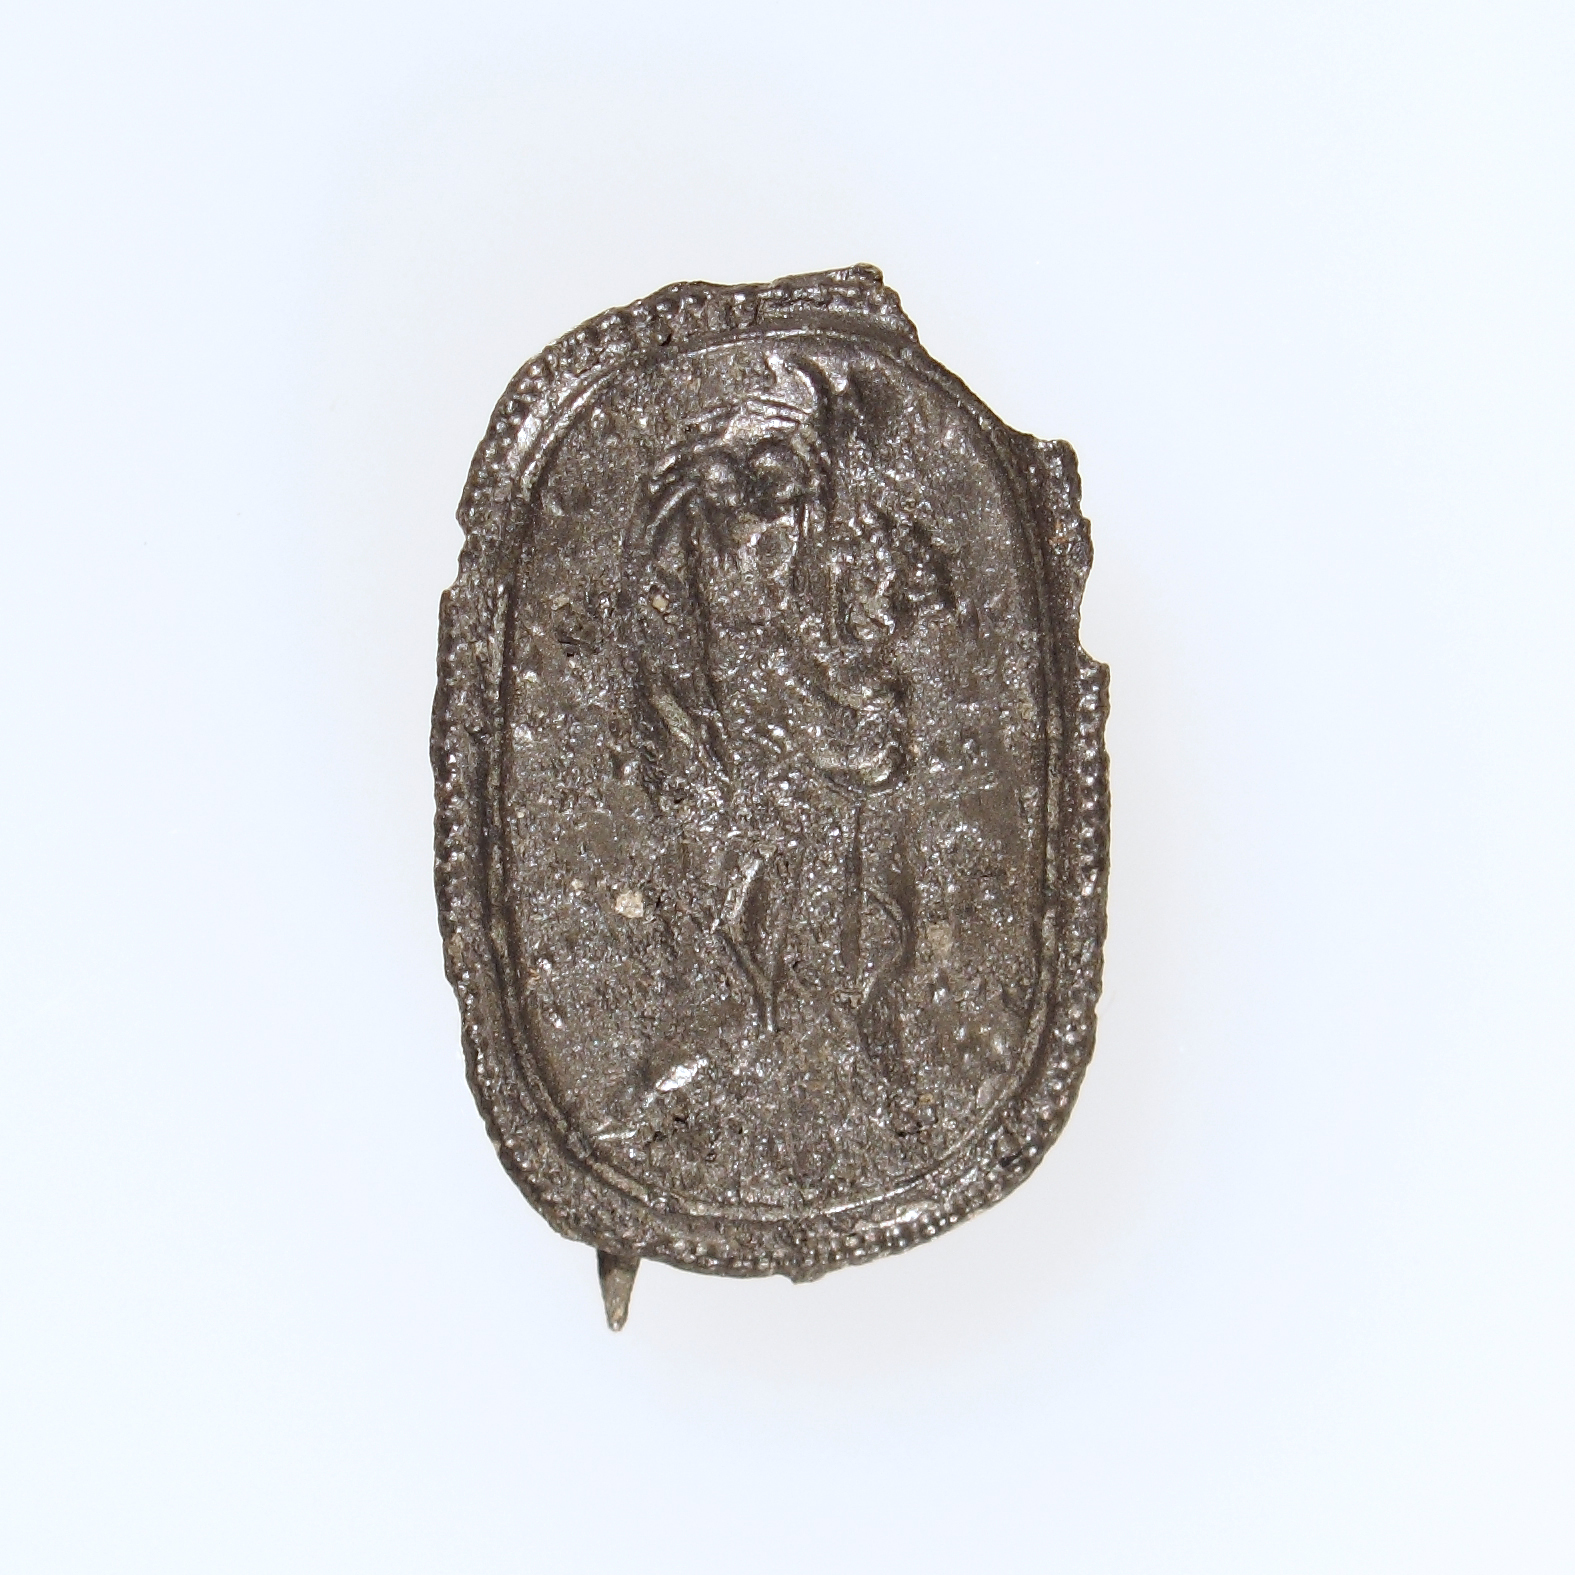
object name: pilgrim's badge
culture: french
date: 1301-1600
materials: lead